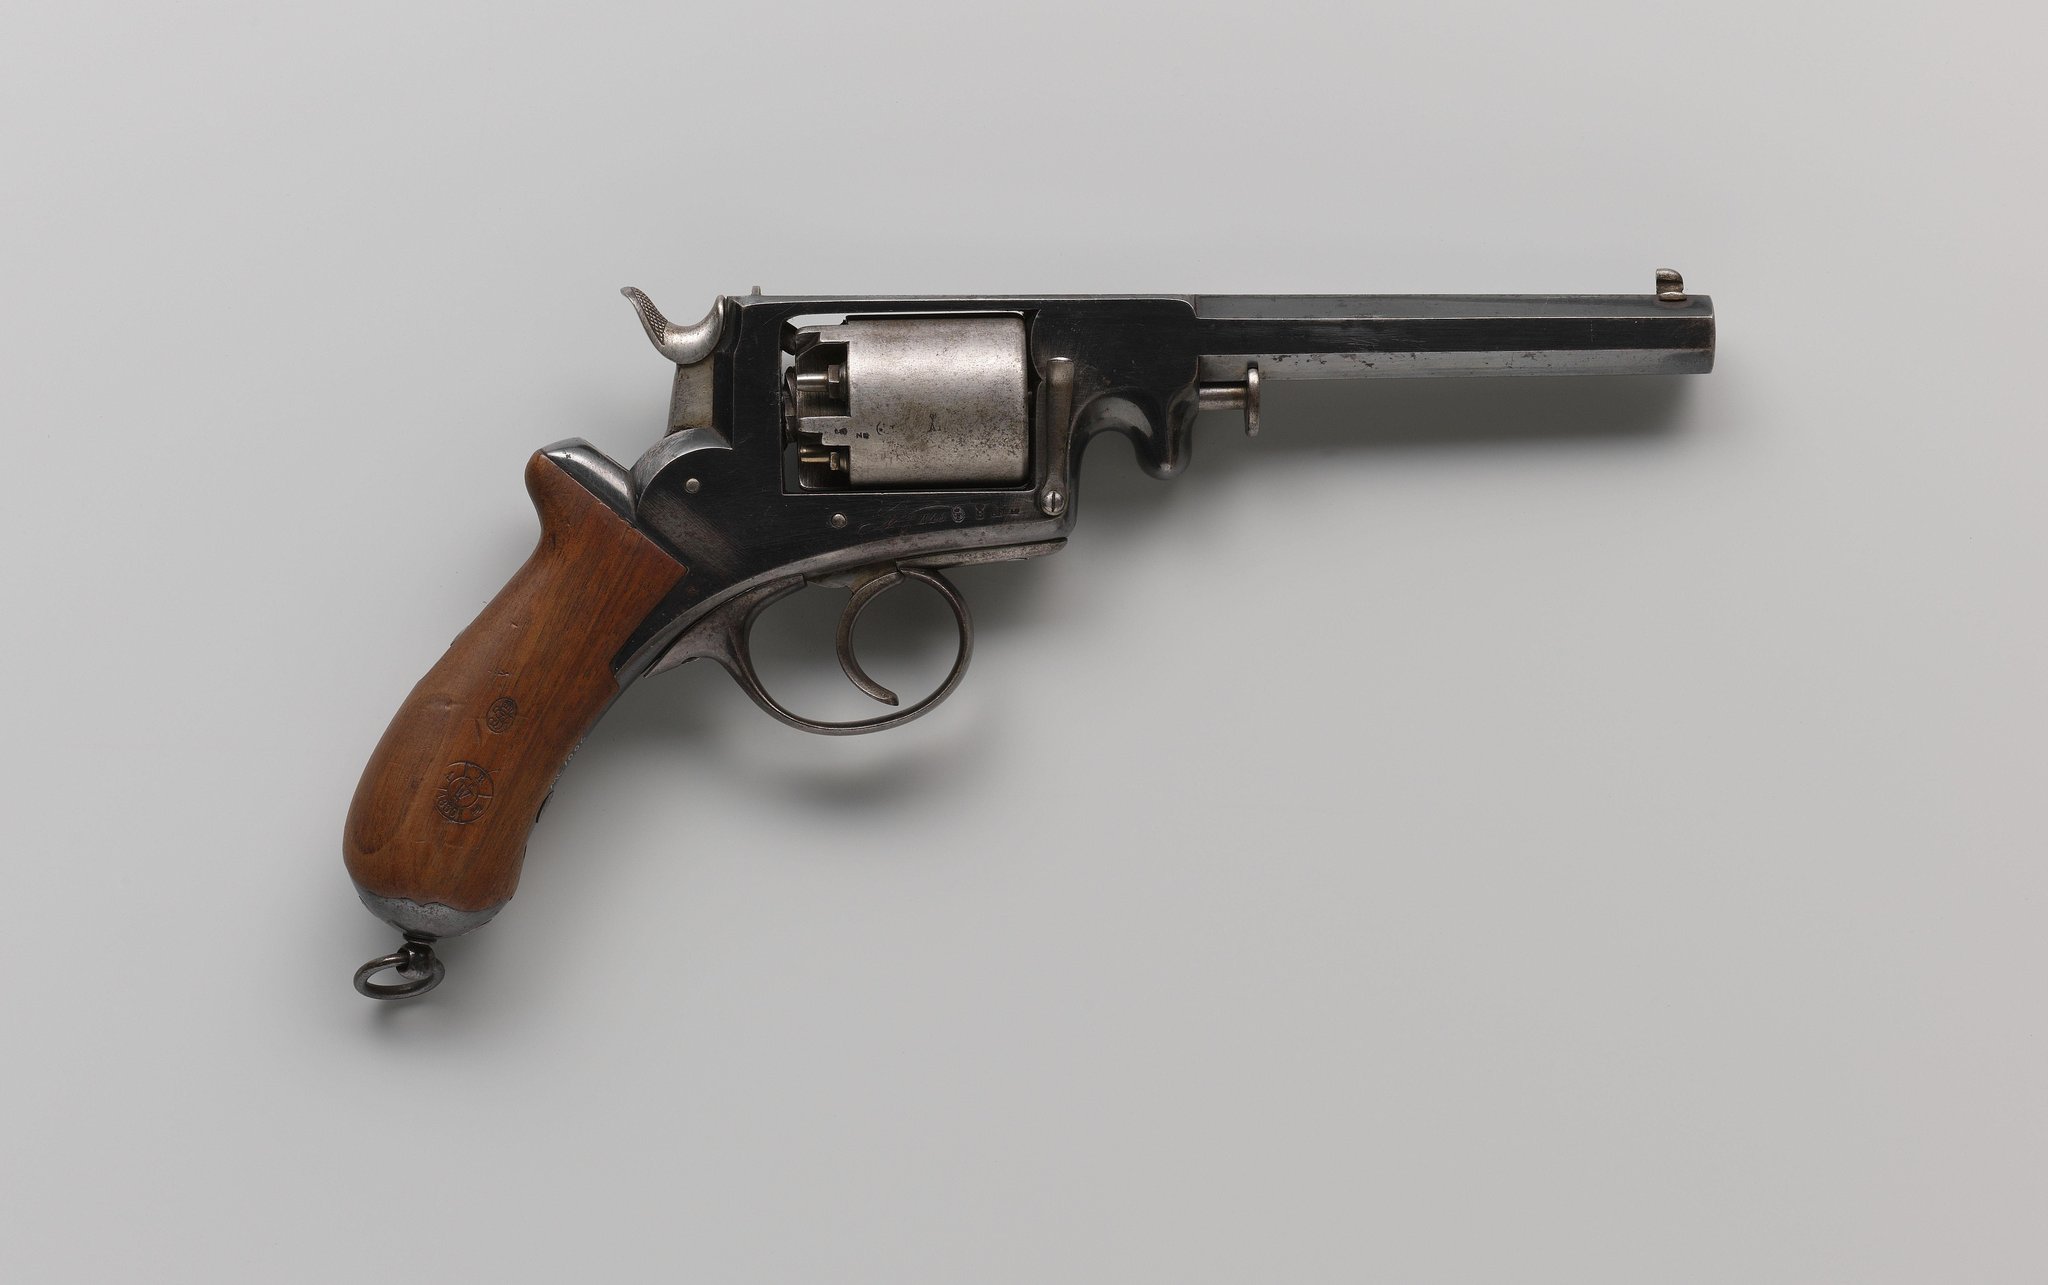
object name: revolver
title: Percussion revolver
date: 1852-1870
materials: iron, wood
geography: london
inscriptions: inscription, near the cylinder: ‘ADAMS / 1850 / PATENT’, mark: various assayer's marks on all parts, monogram, on the butt: ‘A / R / F / 1860’, inscription, on and below the cylinder: ‘Nº 846’, inscription, on the barrel: ‘A. FRANCOTTE À LIÉGE’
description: Deane-Adams revolver, getrokken zesschoots percussie. De revolver is van geblauwd staal met een ijzeren cylinder, haan en trekker. Hij heeft een achttkantige loop. De patronen moeten voor in de cylinder worden aangebracht, waarbij zij door middel van een stamper aan een hefboom langs de loop kunnen worden aangestampt. De slaghoedjes worden op schoorsteentjes aan de achterkant van de cylinder aangebracht.